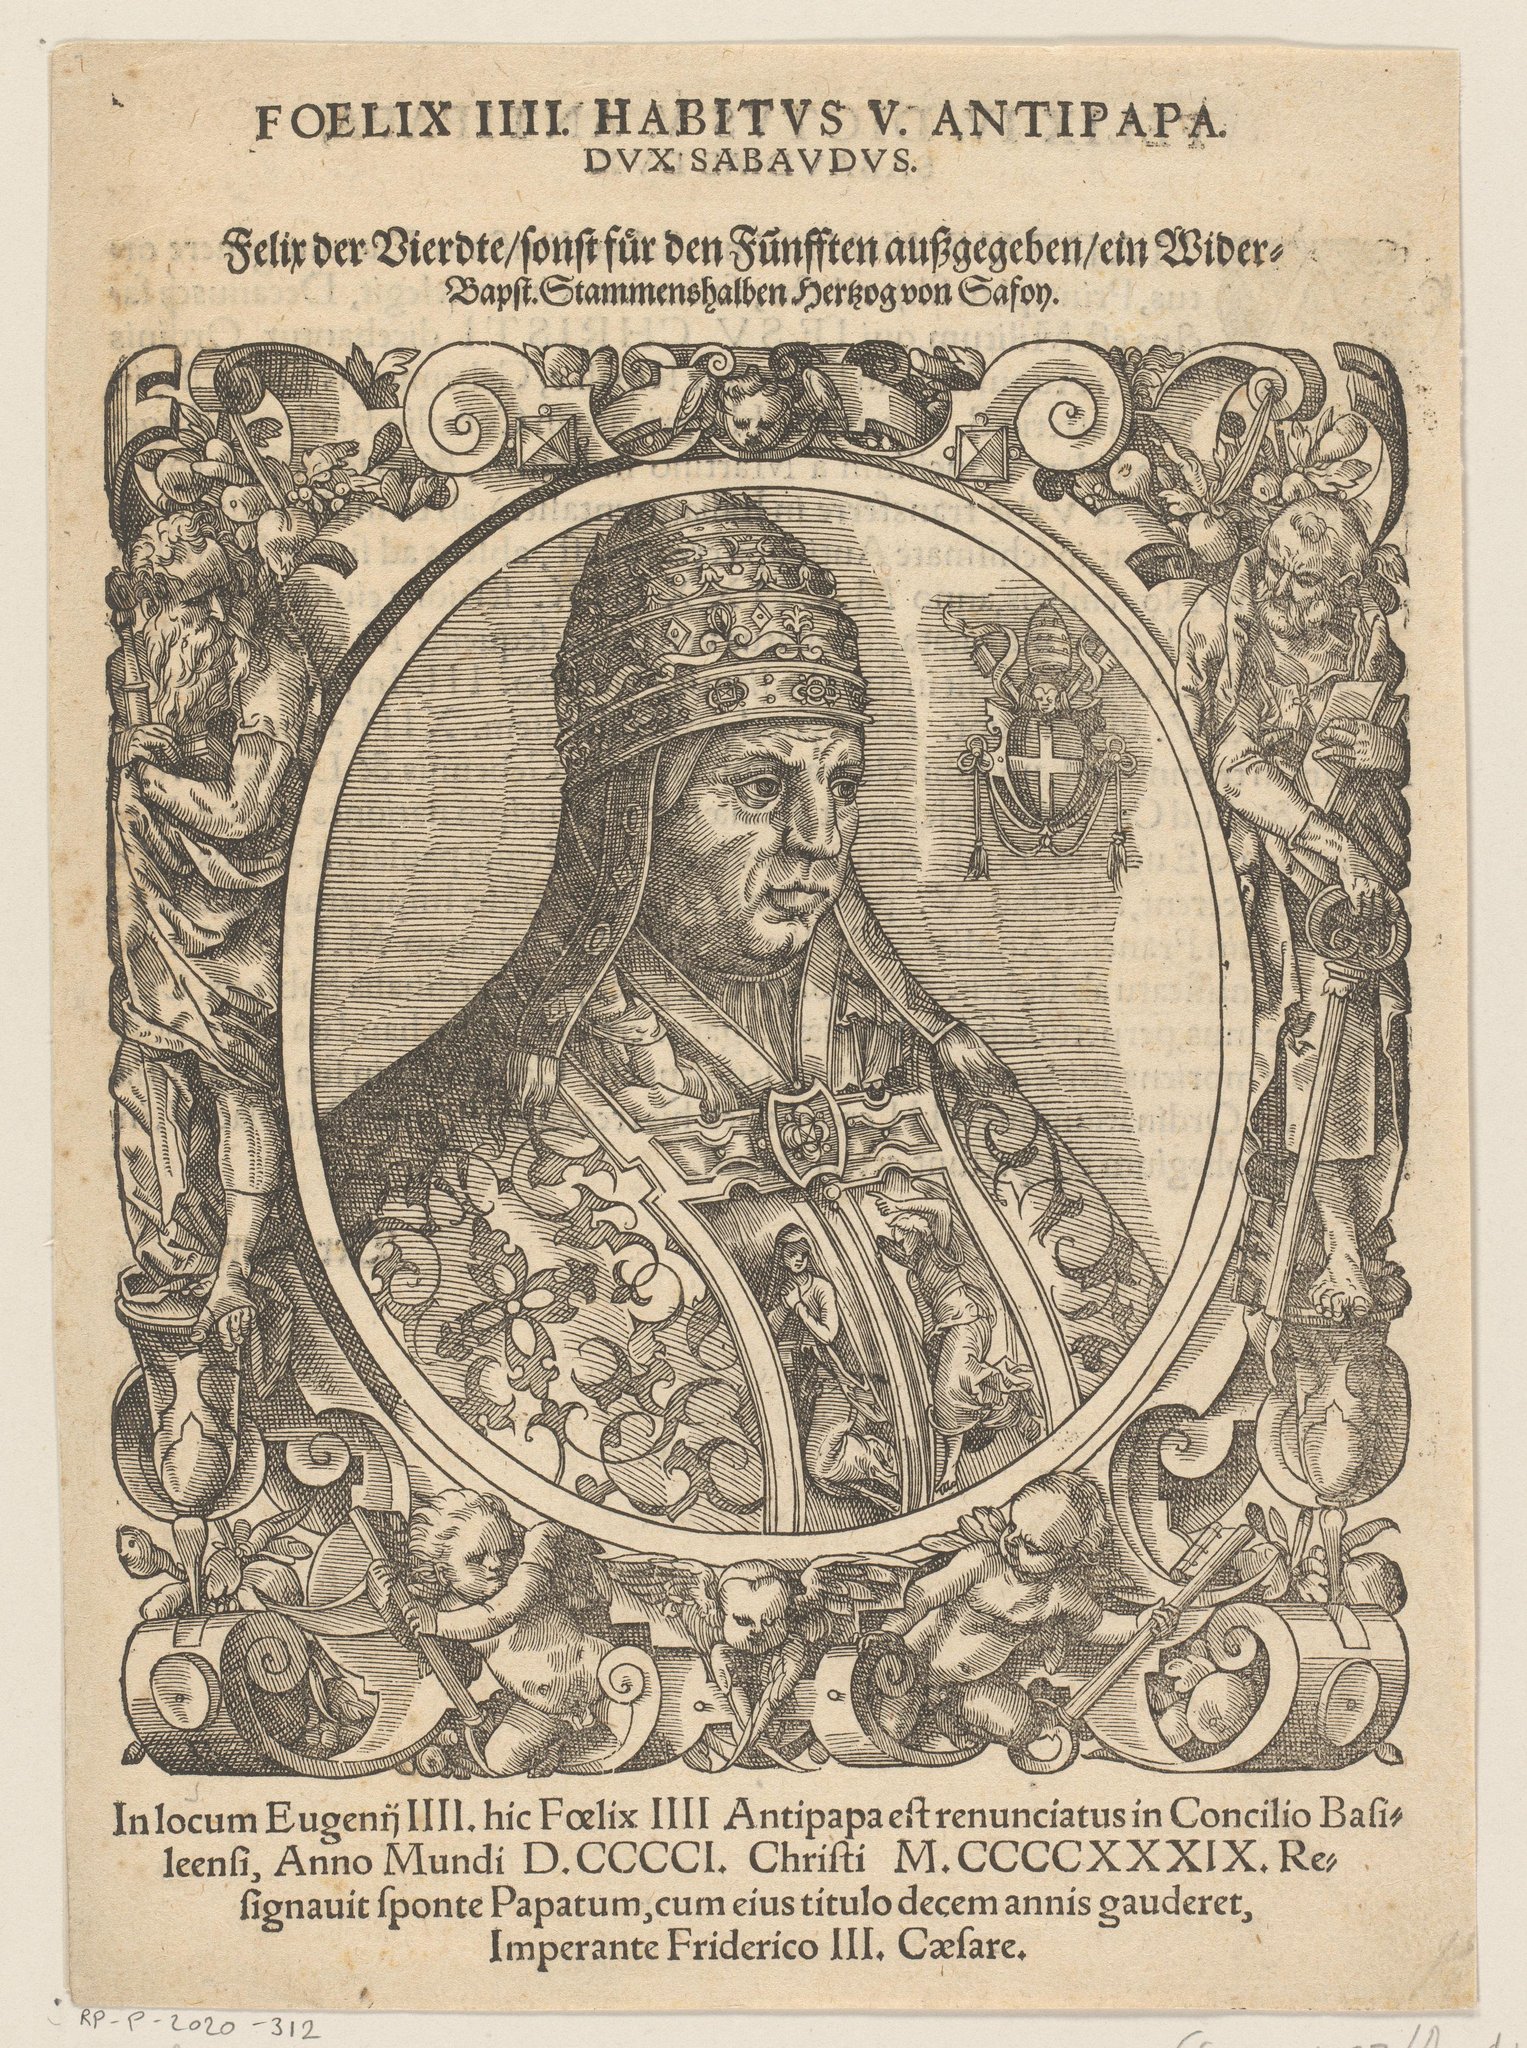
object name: print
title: Portret van tegenpaus Felix V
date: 1573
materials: paper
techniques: letterpress printing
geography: straatsburg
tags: historical persons, pope, armorial bearing, heraldry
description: Prent uit: Accuratae effigies pontificum maximorum, numero XXVIII (...). Straatsburg: Bernhard Jobin, 1573.